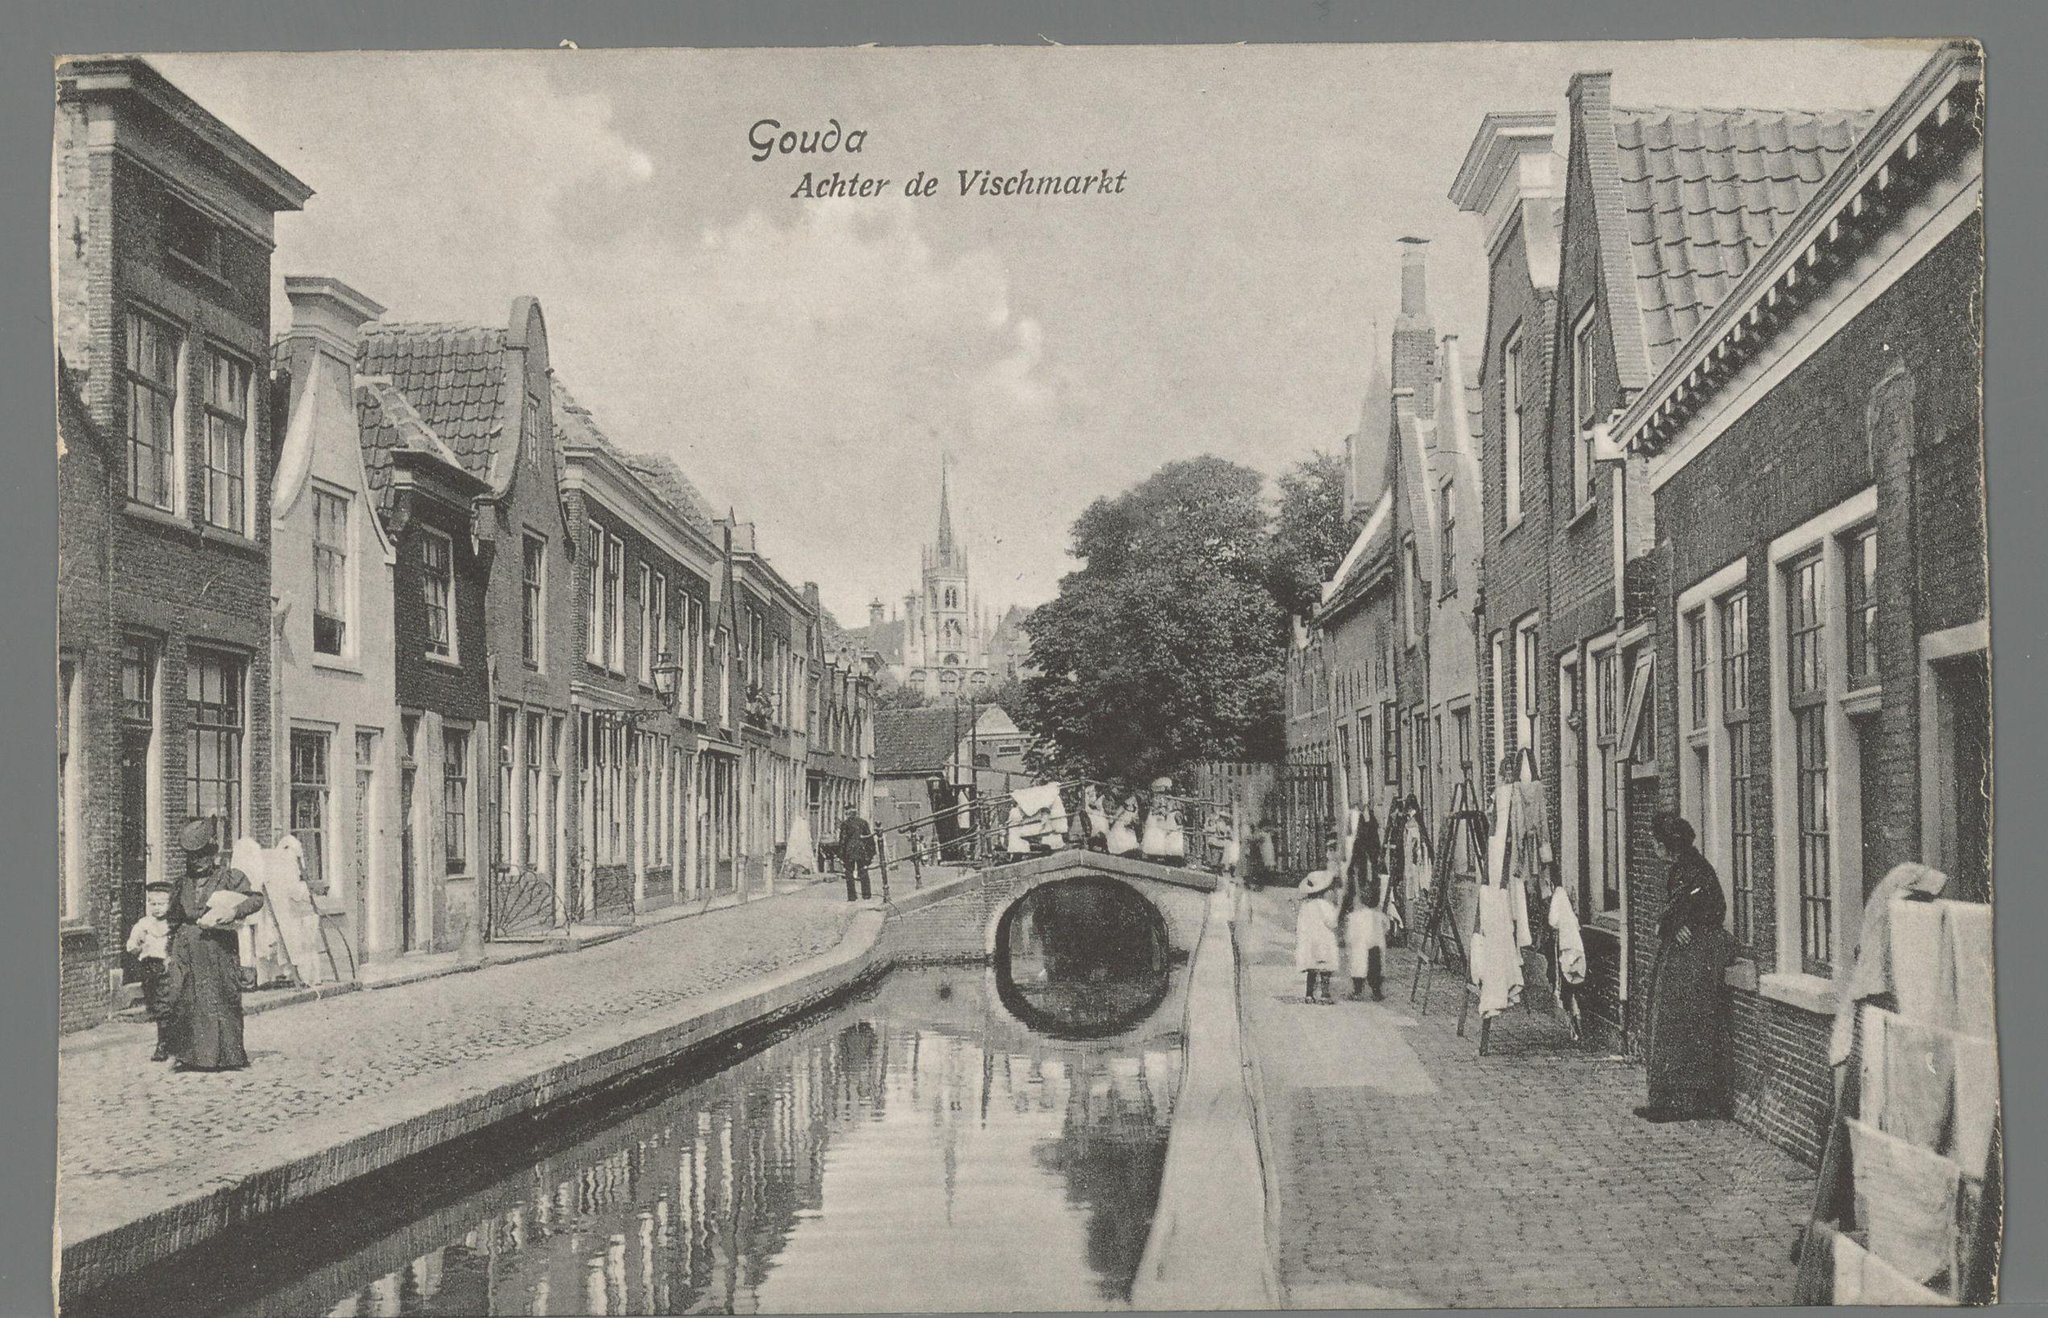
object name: photomechanical print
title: Gouda. Achter de Vischmarkt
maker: Anonymous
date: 1908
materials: cardboard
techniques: photograph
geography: gouda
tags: canals, waters (in village), church (exterior), street, bridge in village across river, canal, etc., gouda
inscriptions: date